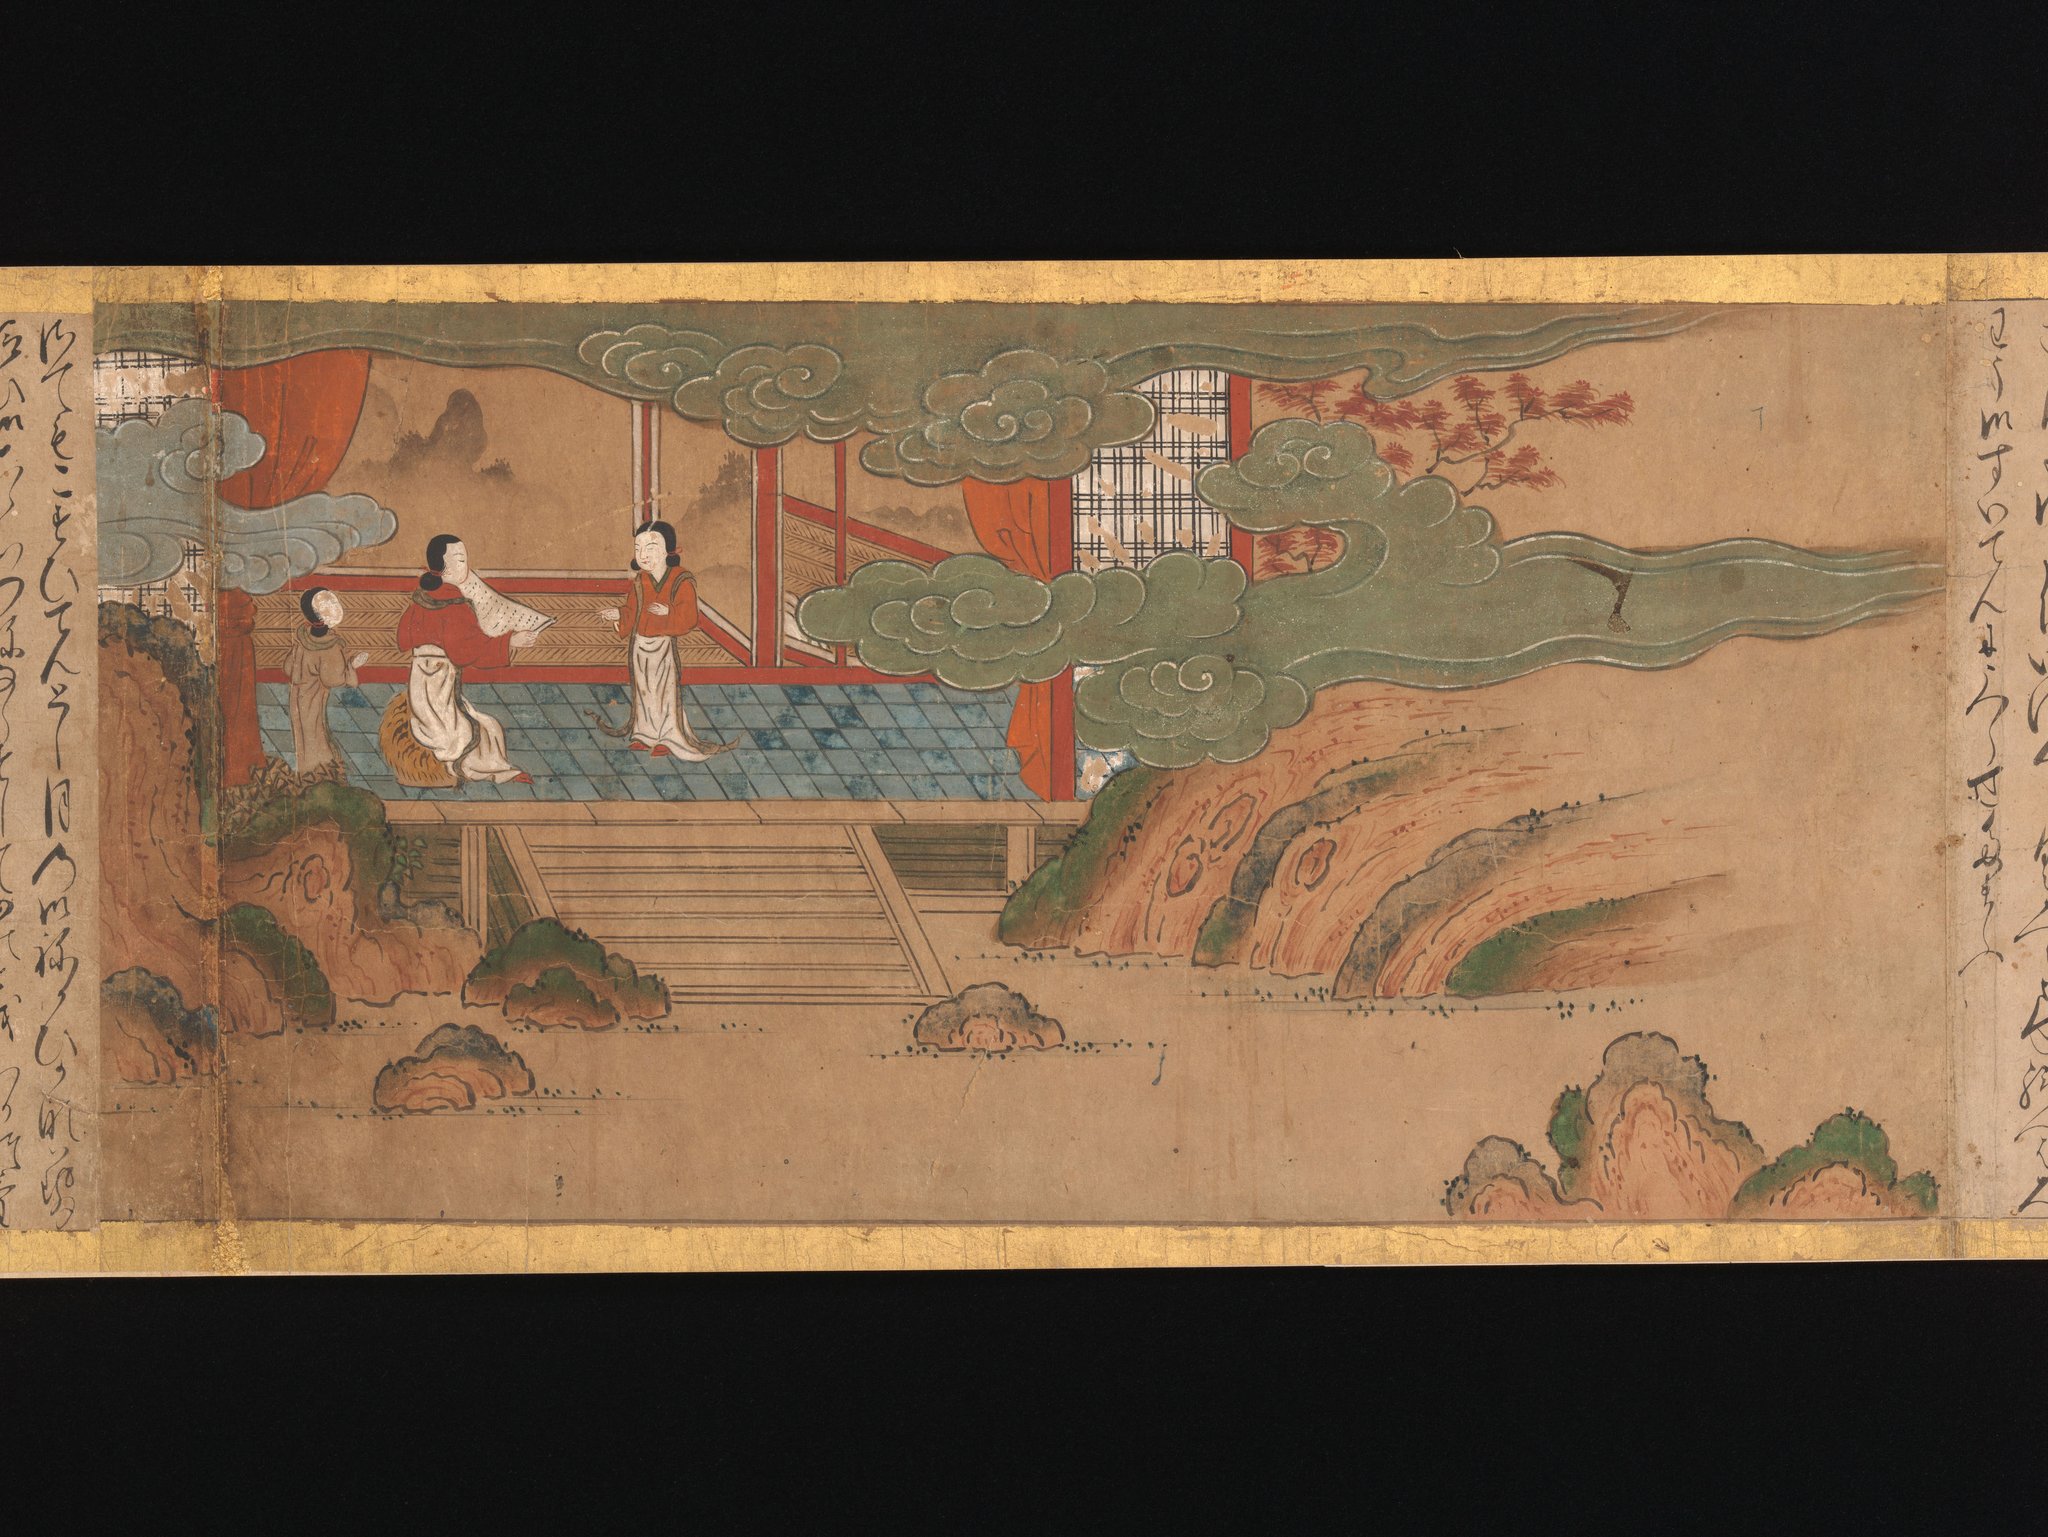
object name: handscroll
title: Illustrated Legends of the Origins of the Kumano Shrines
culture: japanese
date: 1567-1633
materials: ink, paper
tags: men,women,horses,pavilions